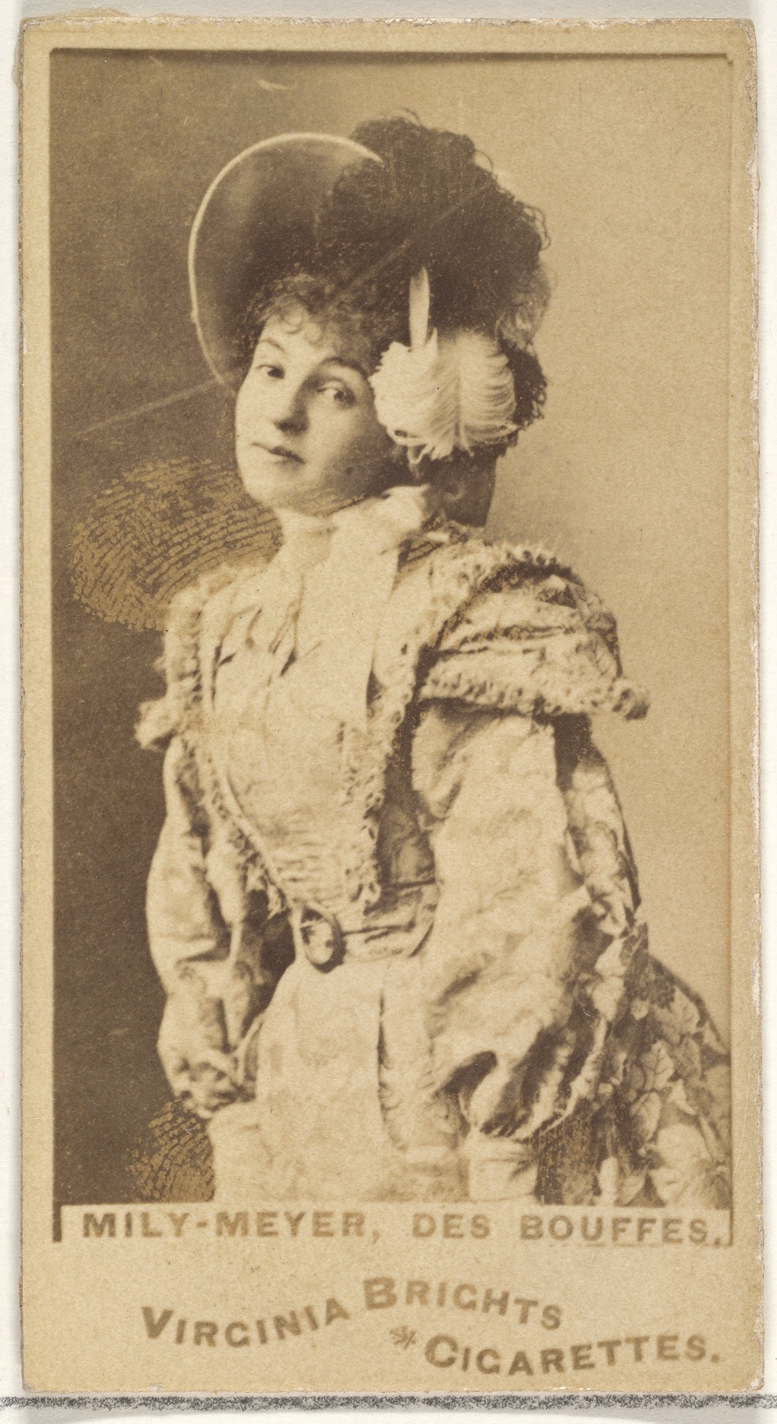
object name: photograph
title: Mily-Meyer, Des Bouffes, from the Actors and Actresses series (N45, Type 1) for Virginia Brights Cigarettes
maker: allen & ginter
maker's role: publisher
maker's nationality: american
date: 1888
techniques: albumen silver print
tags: portraits,women,actresses